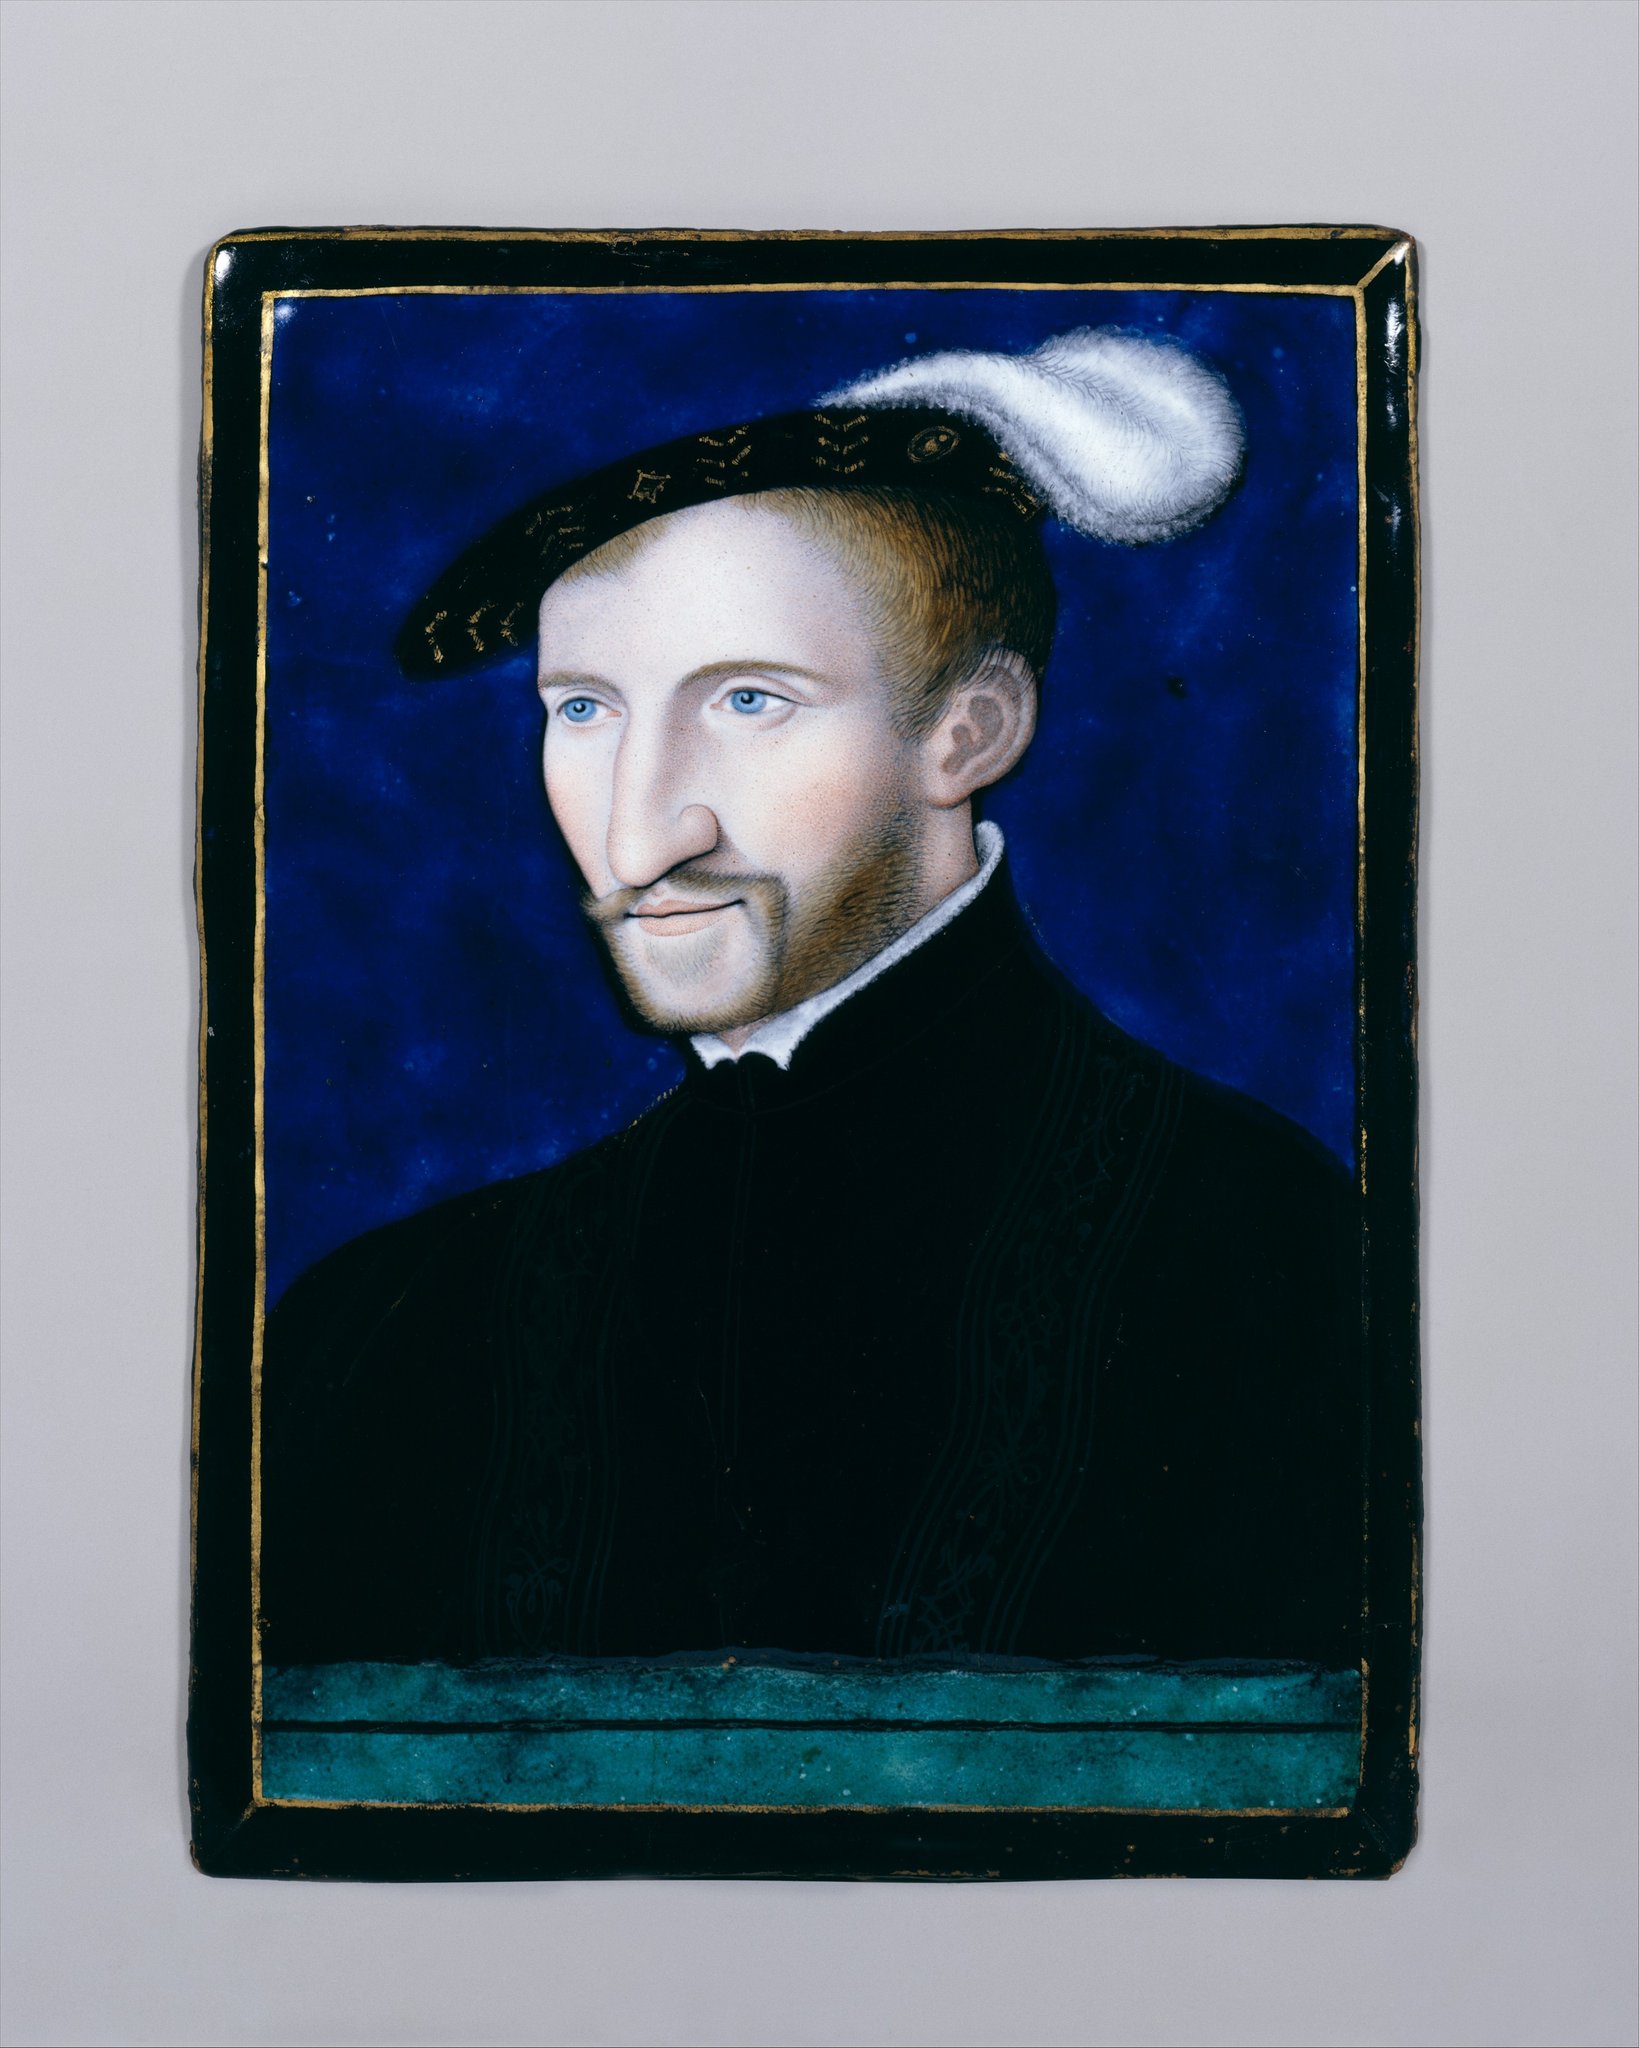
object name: plaque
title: Henri d'Albret (1503–55), King of Navarre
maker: léonard limosin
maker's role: artist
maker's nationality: french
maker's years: 1505-1577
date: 1556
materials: copper, enamel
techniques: gilding, painting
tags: men,portraits